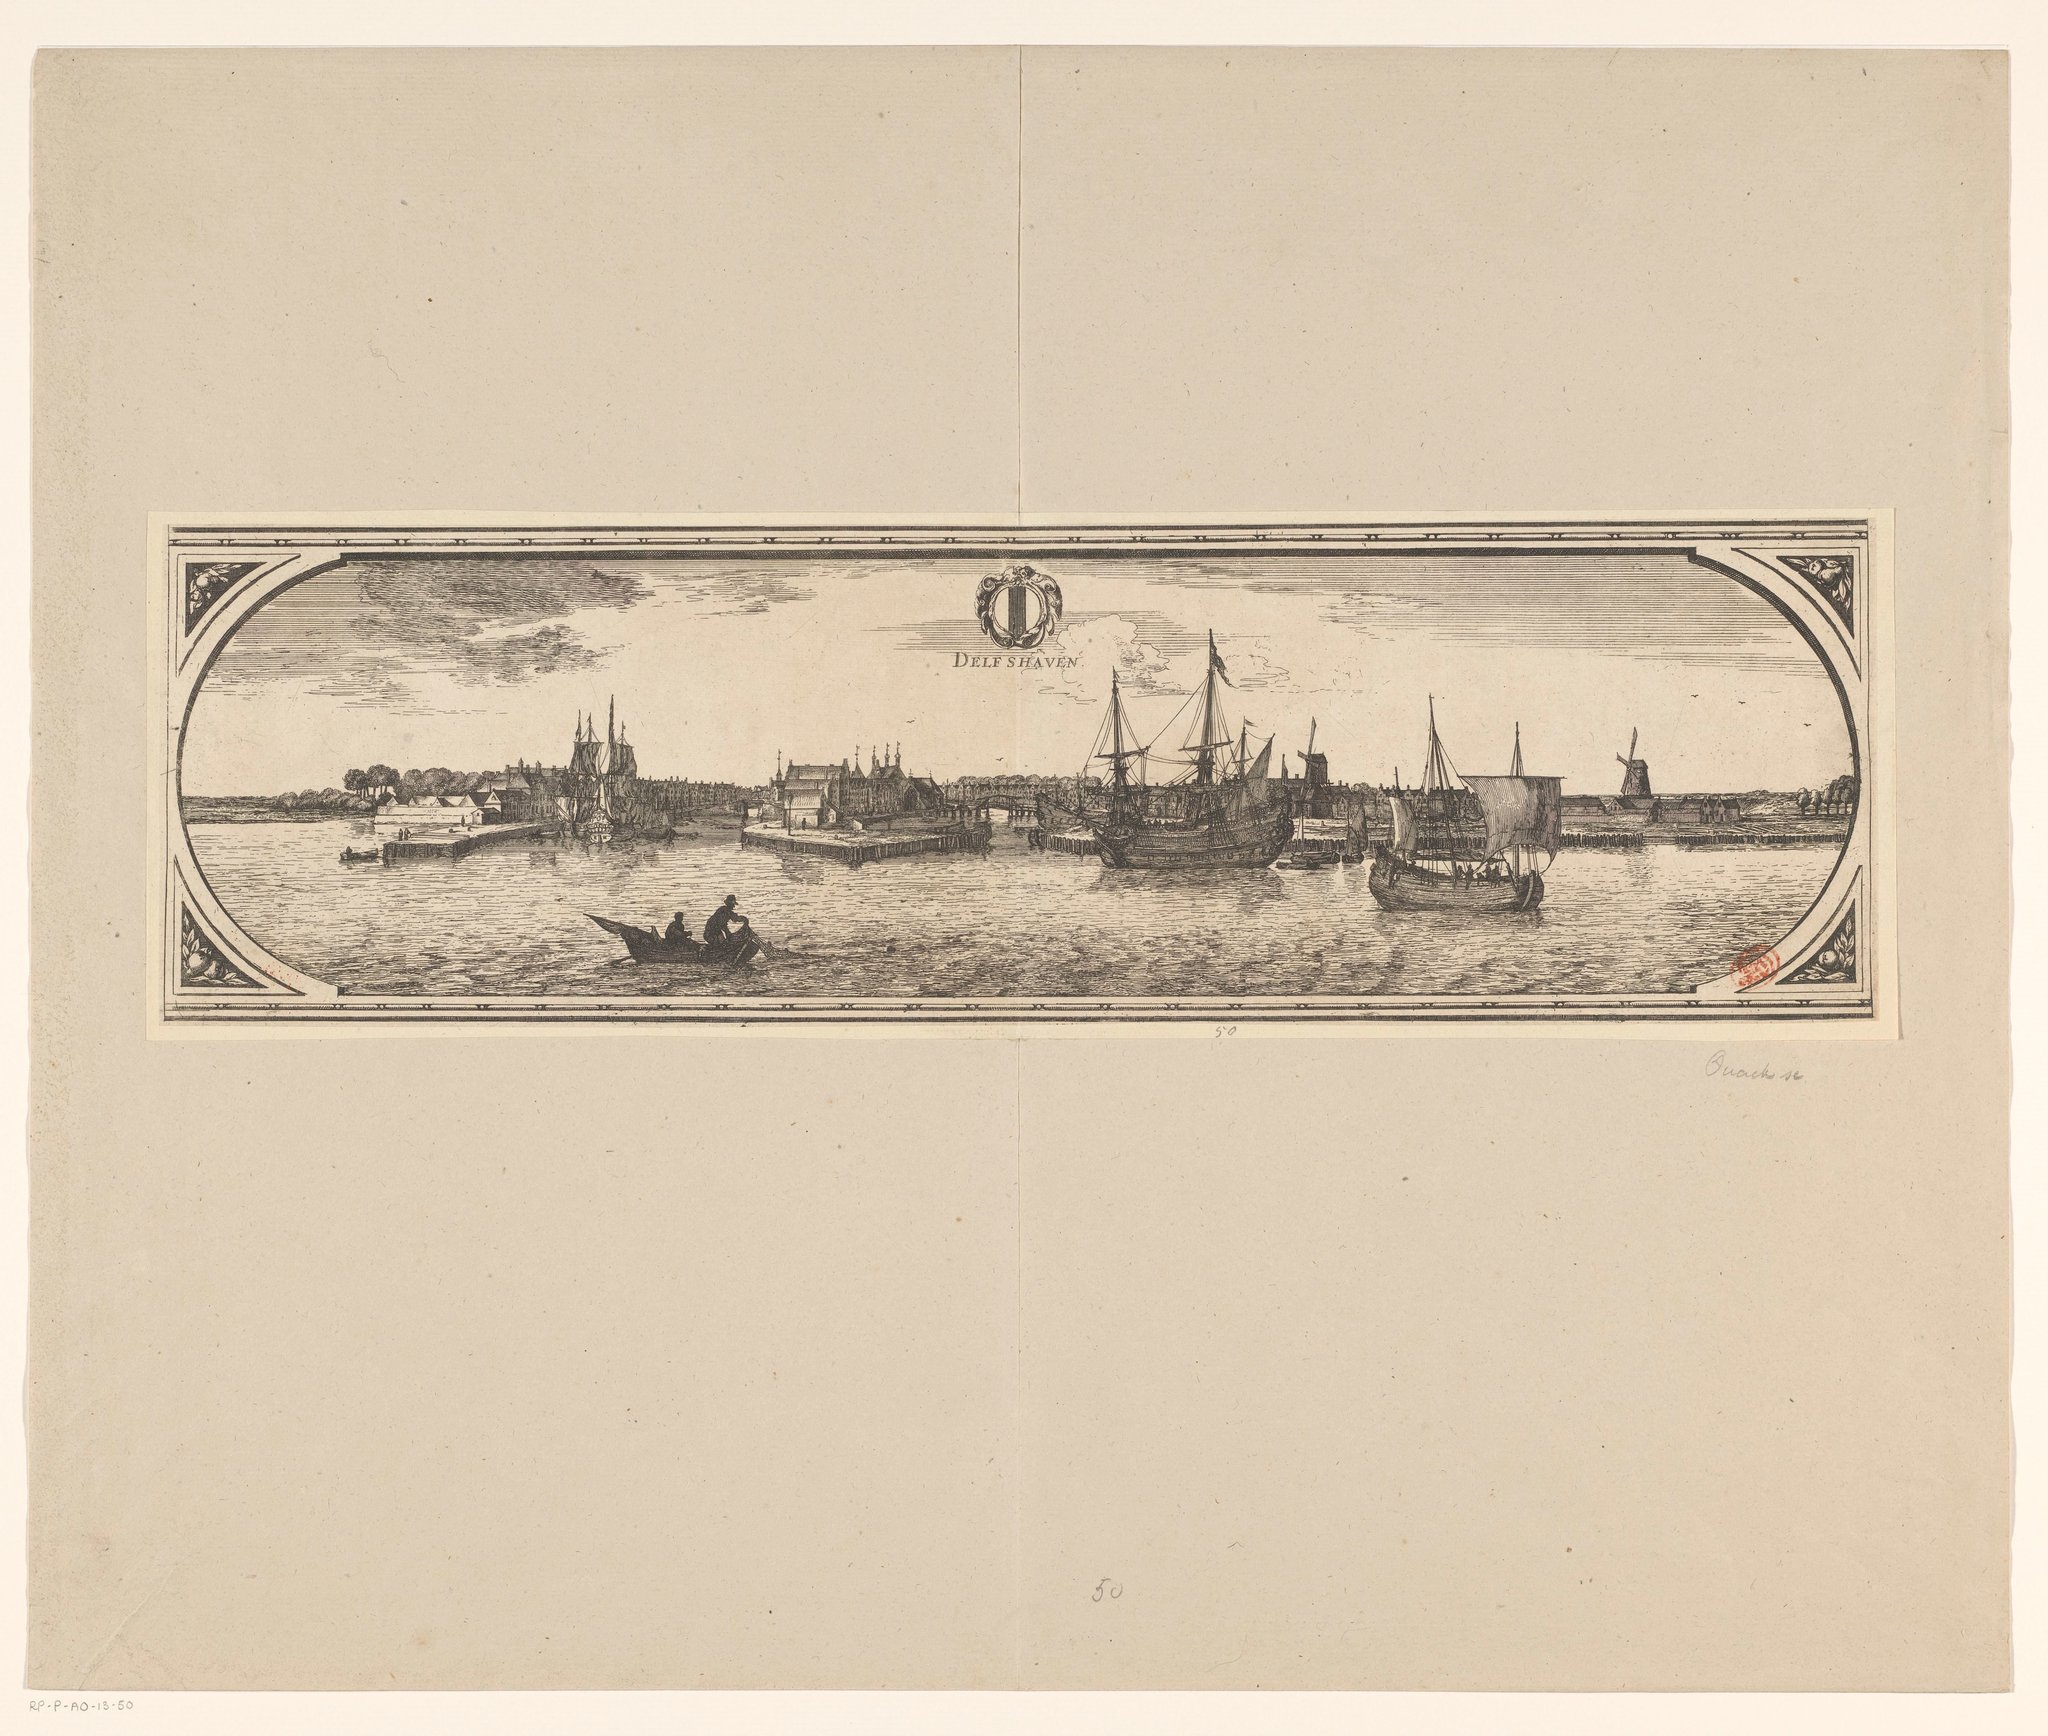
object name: print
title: Delfshaven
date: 1666-1698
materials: paper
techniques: etching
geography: rotterdam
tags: coat of arms (as symbol of the state, etc.) (+ city; municipal), sailing-ship, sailing-boat, windmill, prospect of city, town panorama, silhouette of city, fisherman, delfshaven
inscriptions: collector's mark: Lugt 195, collector's mark: Lugt 2228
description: Gezicht op Delfshaven gezien vanaf de Nieuwe Maas. In het water een vissersboot en enkele zeilschepen. Boven in het midden het wapen van Delft (waar Delfshaven destijds toe behoorde) en de titel.